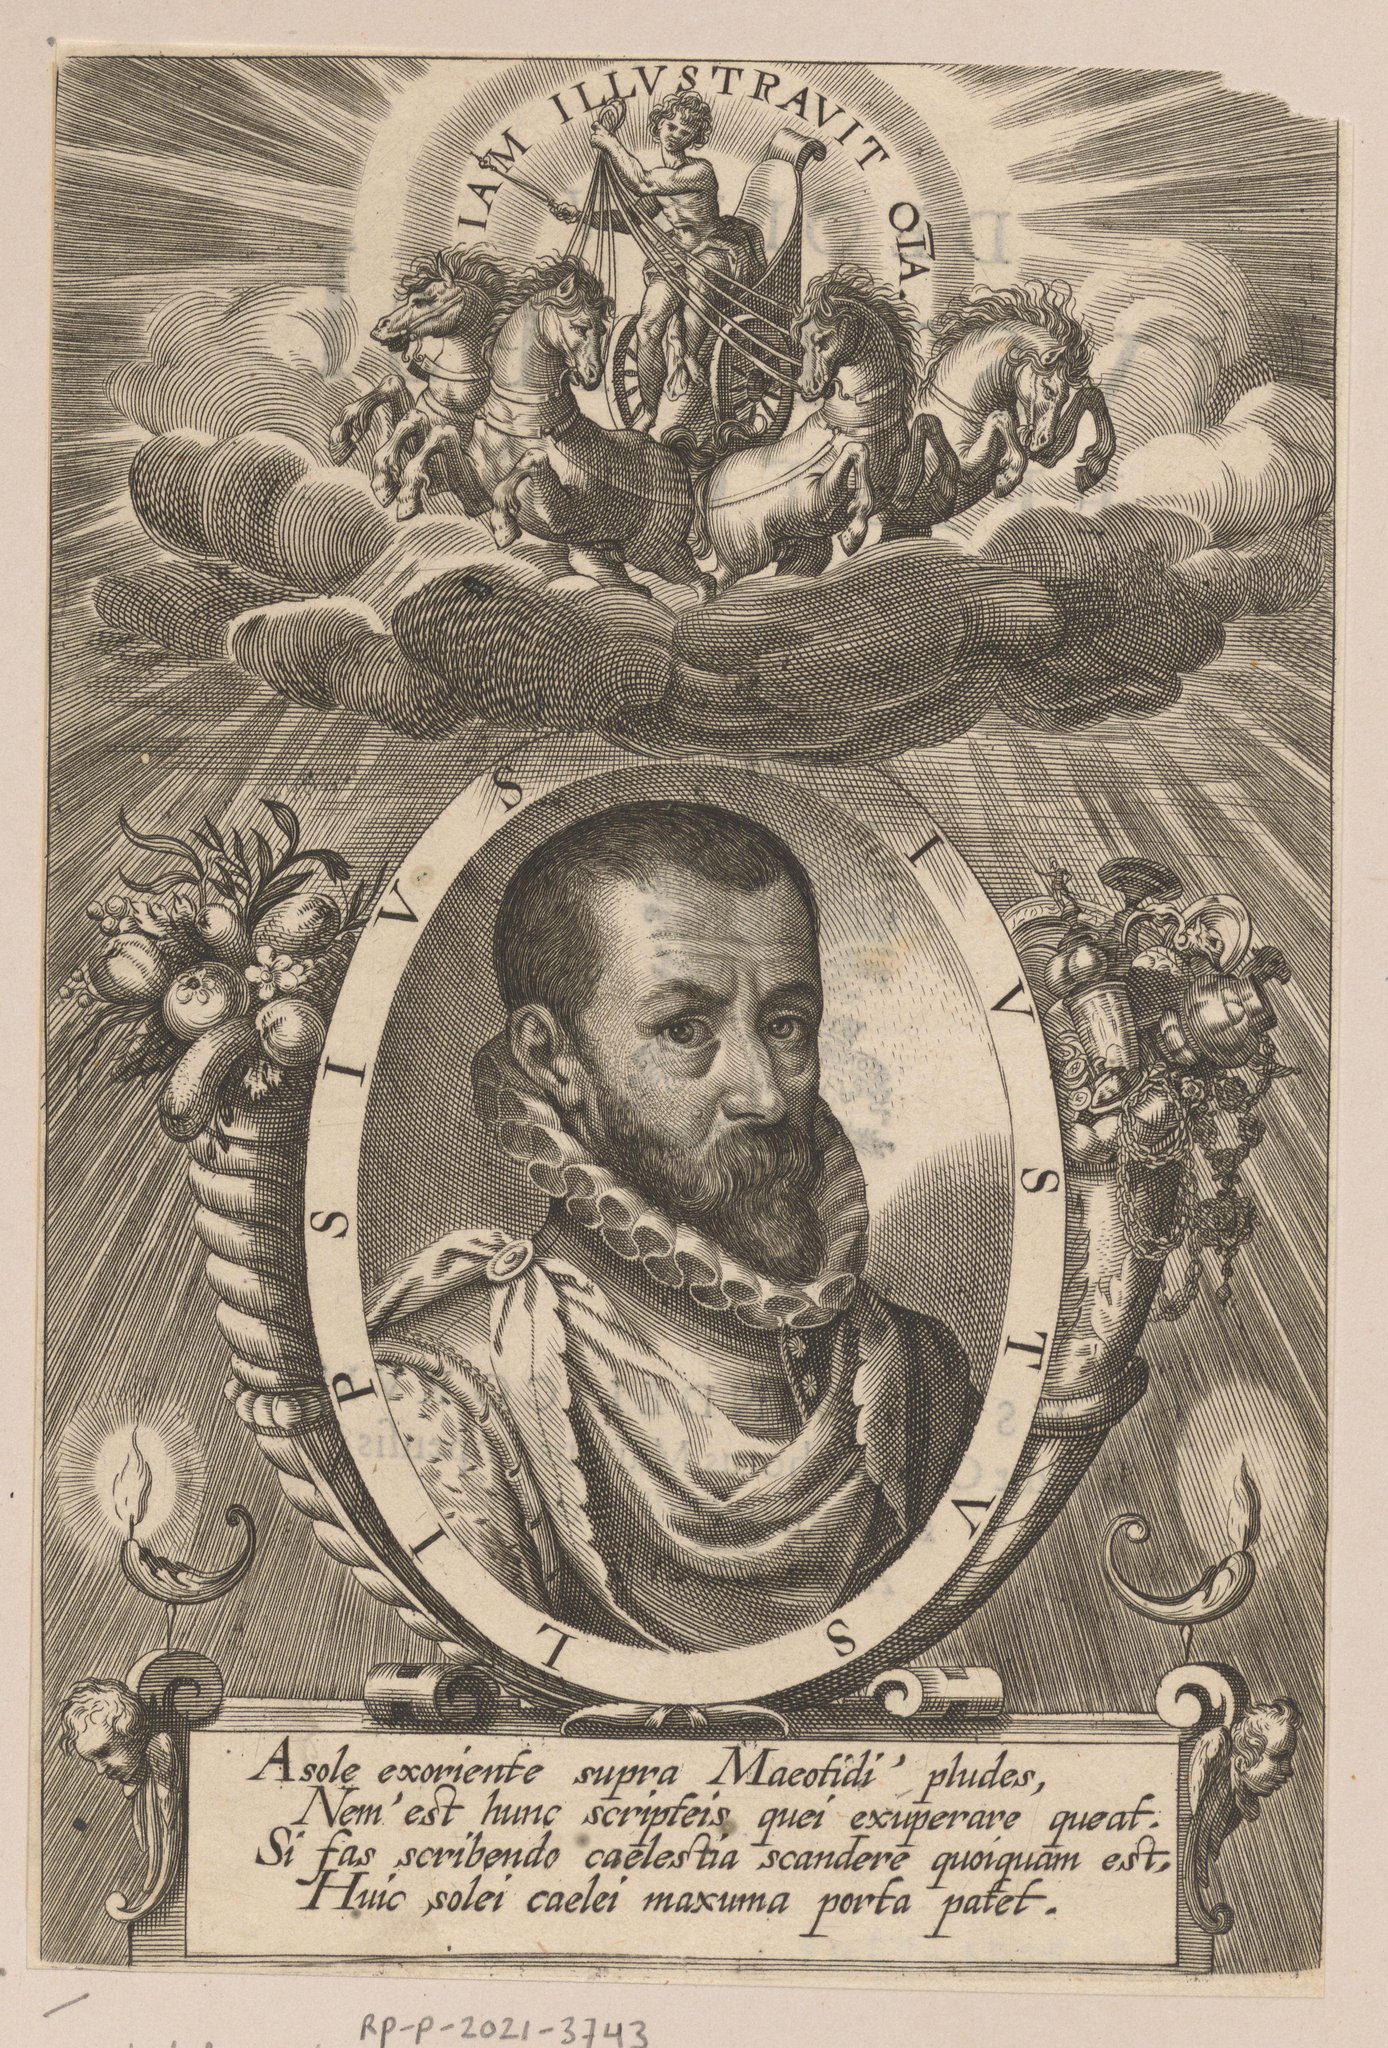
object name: print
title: Portret van Justus Lipsius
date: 1606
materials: paper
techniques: engraving, letterpress printing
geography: germany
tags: louvain, justus lipsius, history and archaeology (+ portrait of scholar, scientist), 'cornucopia', horn of plenty, chariot, triumphal car, historical persons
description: Portret in medaillon met aan weerszijden twee Hoornen des Overvloeds. Onder een vierregelig vers in het Latijn. Bovenin een triomfkar met vier paarden.